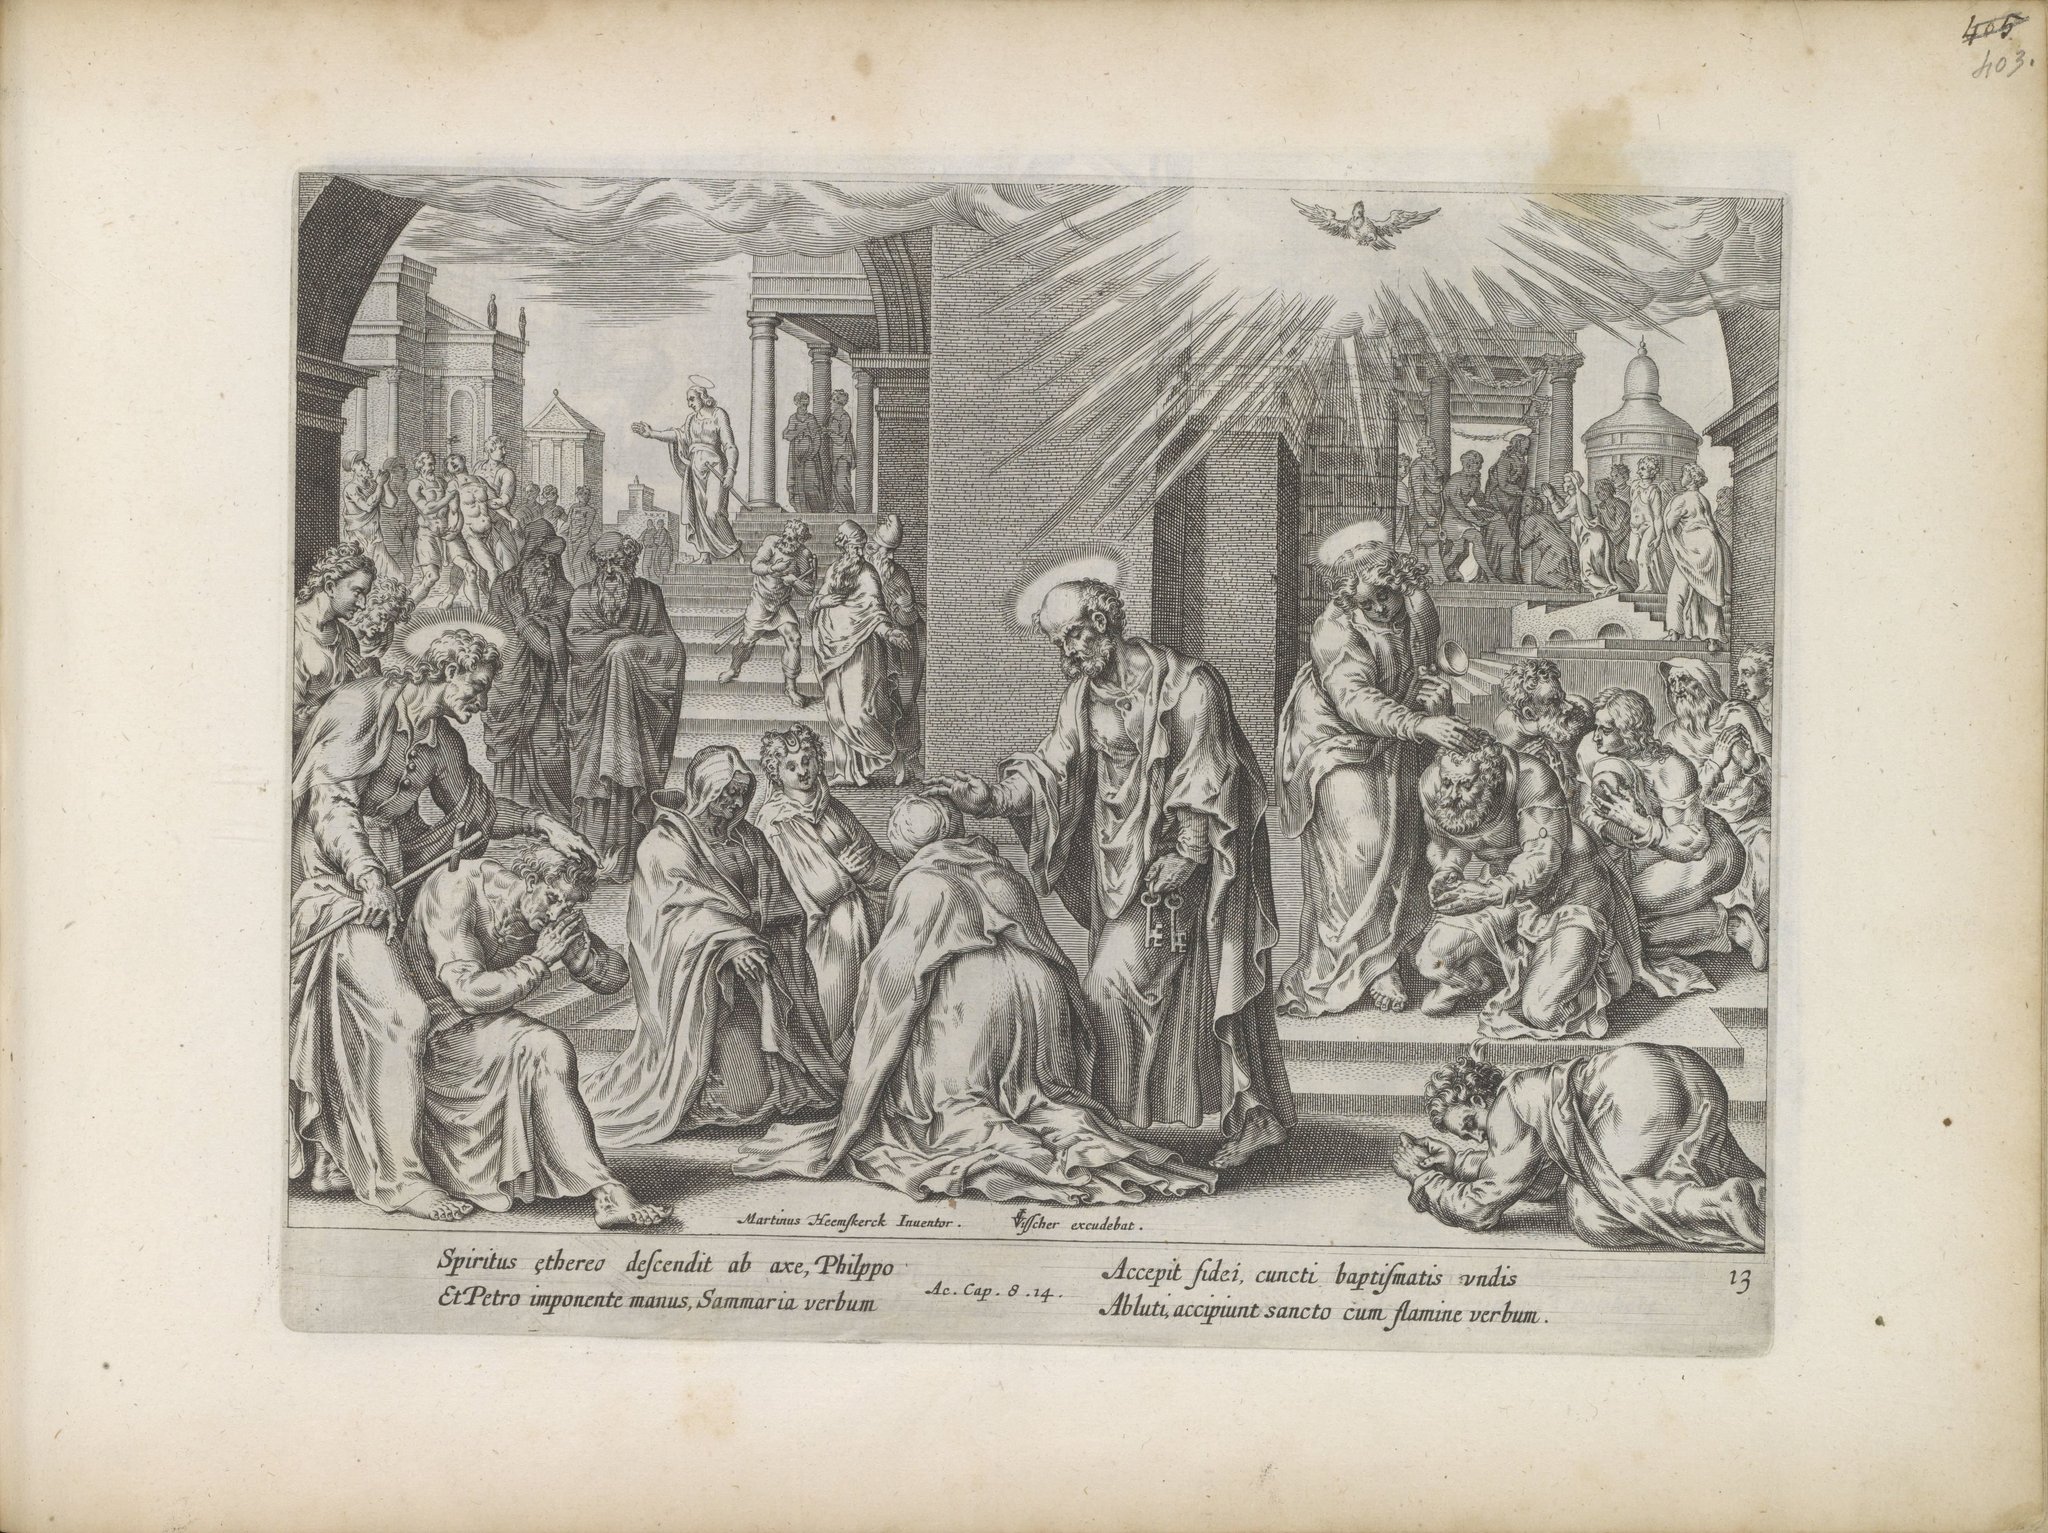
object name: album leaf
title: Handelingen van de apostelen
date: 1643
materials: paper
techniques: engraving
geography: amsterdam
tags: peter and john lay hands on believers in samaria, so that they may receive the holy ghost (acts 8:14-17), philip preaching (in samaria) (acts 8:4-25)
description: De apostelen Petrus, Johannes en Filippus trekken naar Samaria en genezen daar zieken en bezetenen. Op de voorgrond leggen de drie hun handen op gelovigen. Door de handoplegging van de apostelen raken zij vervuld van de Heilige Geest. Die daalt neer in de gedaante van een duif. Onder de voorstelling een verwijzing in het Latijn naar de Bijbeltekst in Hand. 8:14. Deze prent maakt deel uit van een album.